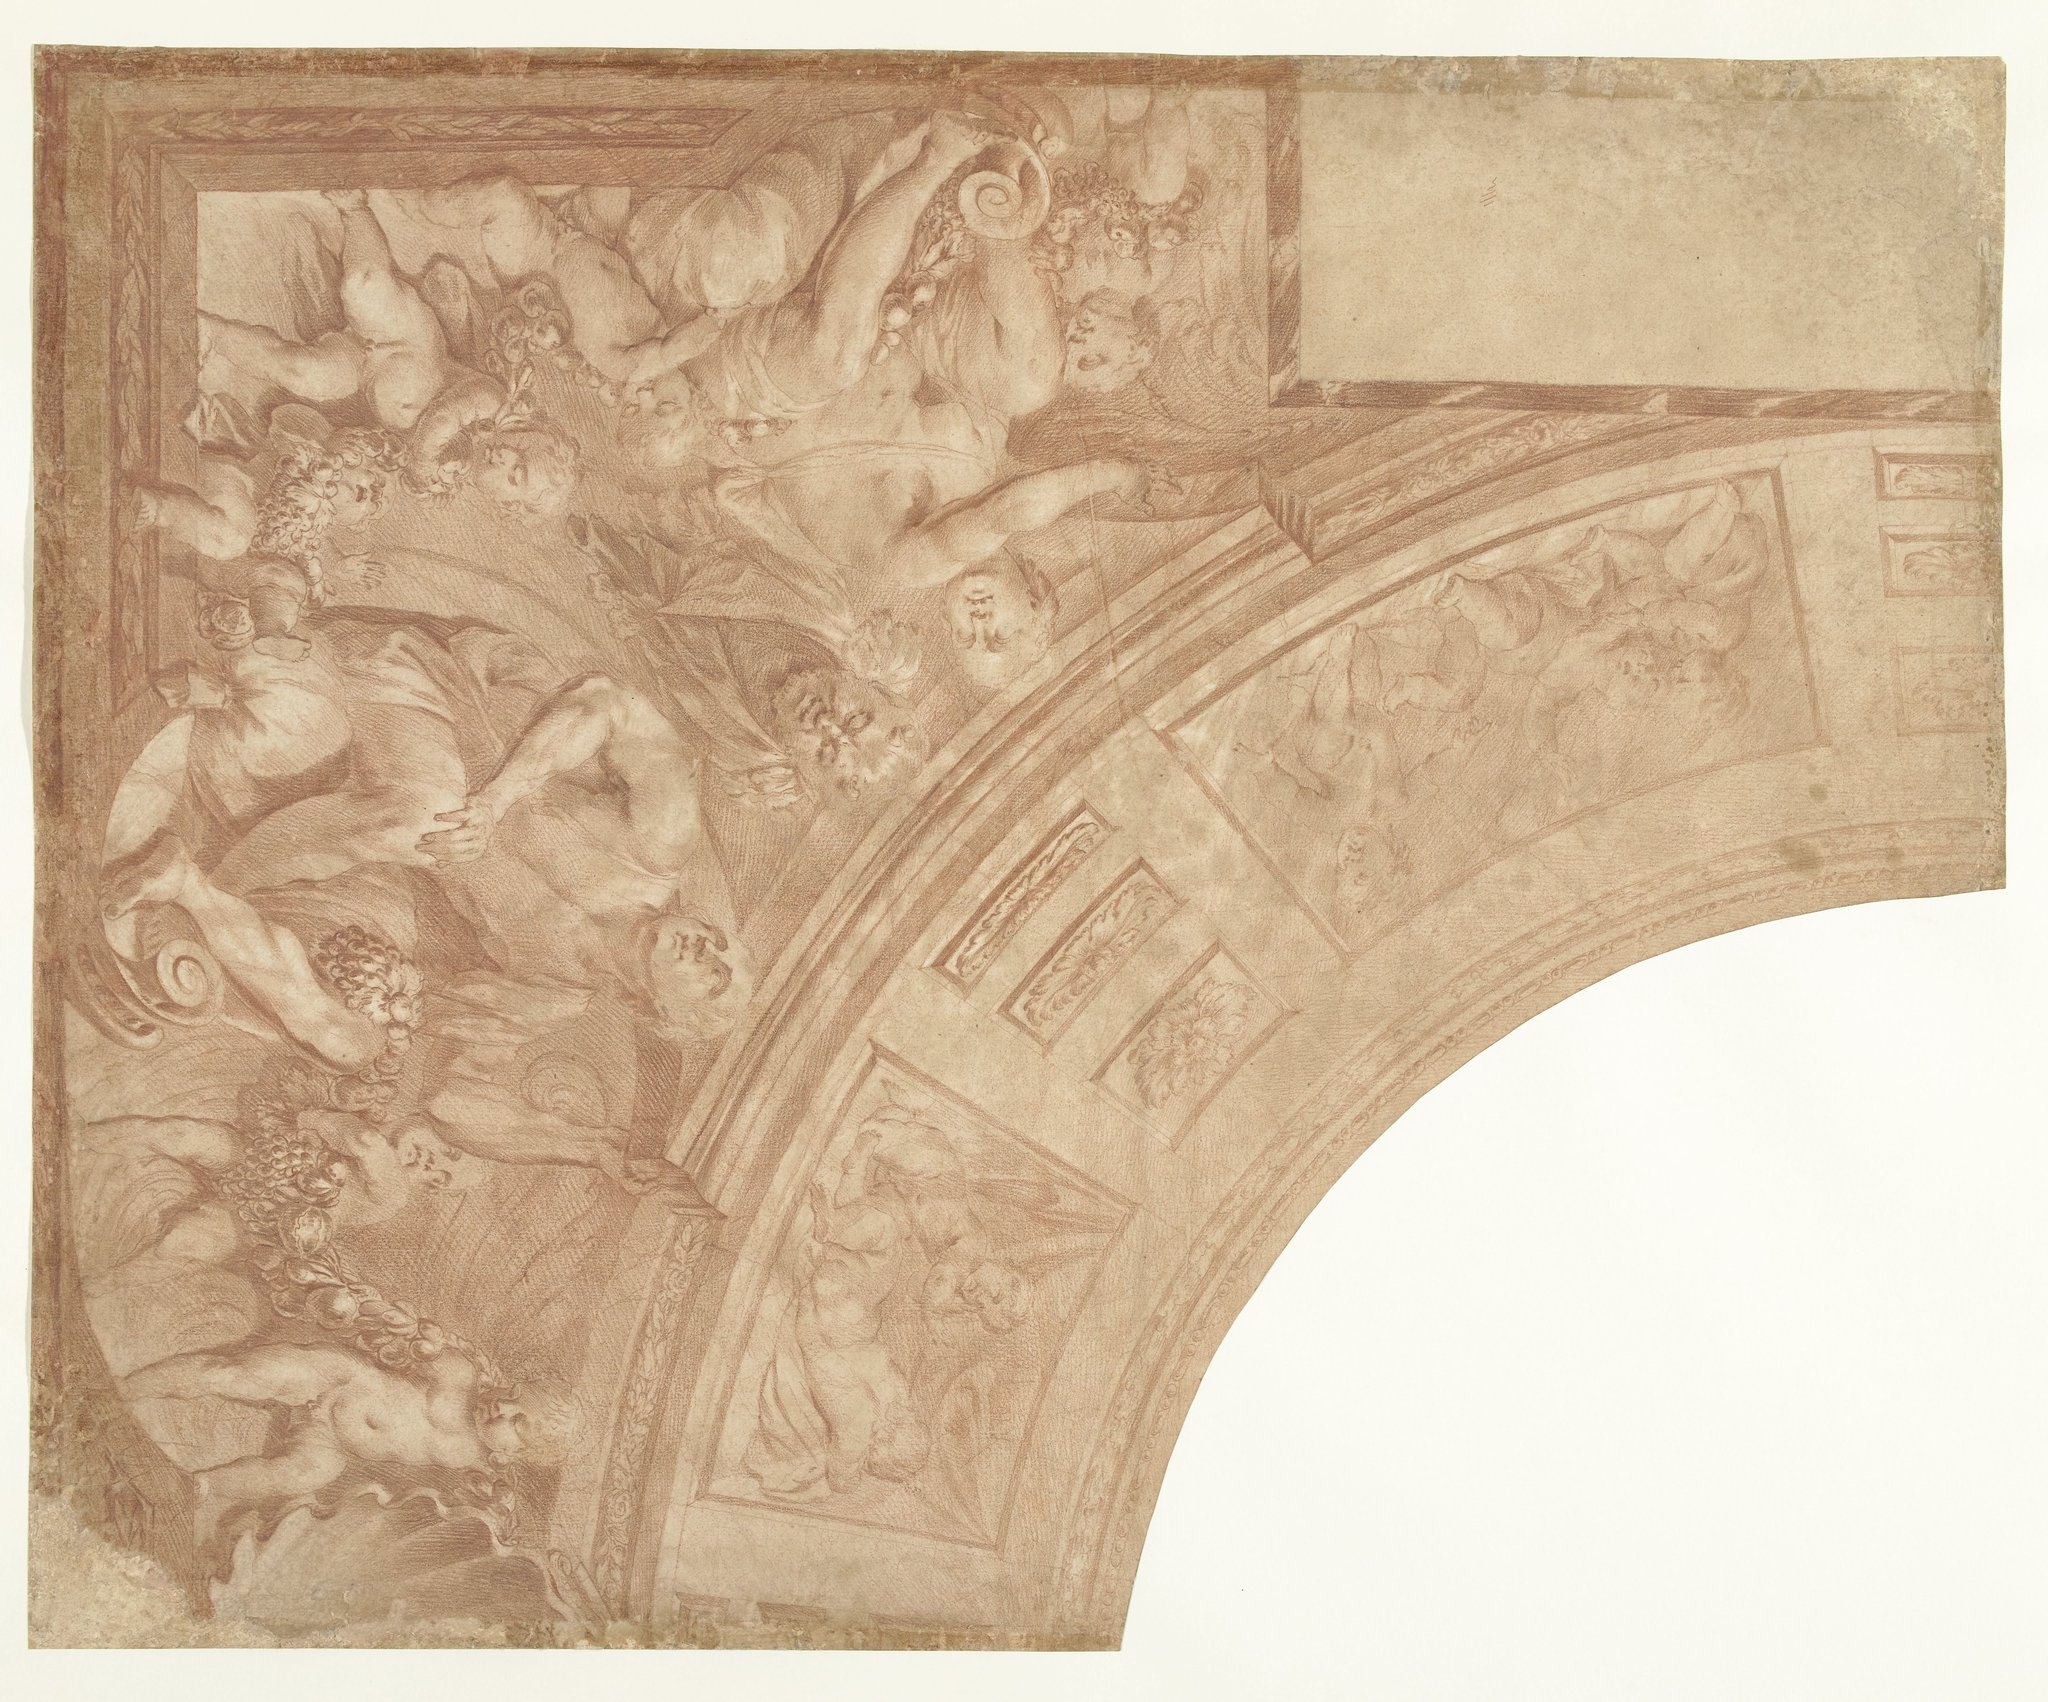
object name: drawing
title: Vier delen van een plafondontwerp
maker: mattheus terwesten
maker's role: draughtsman, painter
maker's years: 1670-1757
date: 1680-1757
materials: chalk, paper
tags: sitting figure, sitting figure - aa - female human figure, ornament ~ human parts, satyr(s) (in general), (decorated) ceiling, ornament ~ festoon, garland, cupids: 'amores', 'amoretti', 'putti'